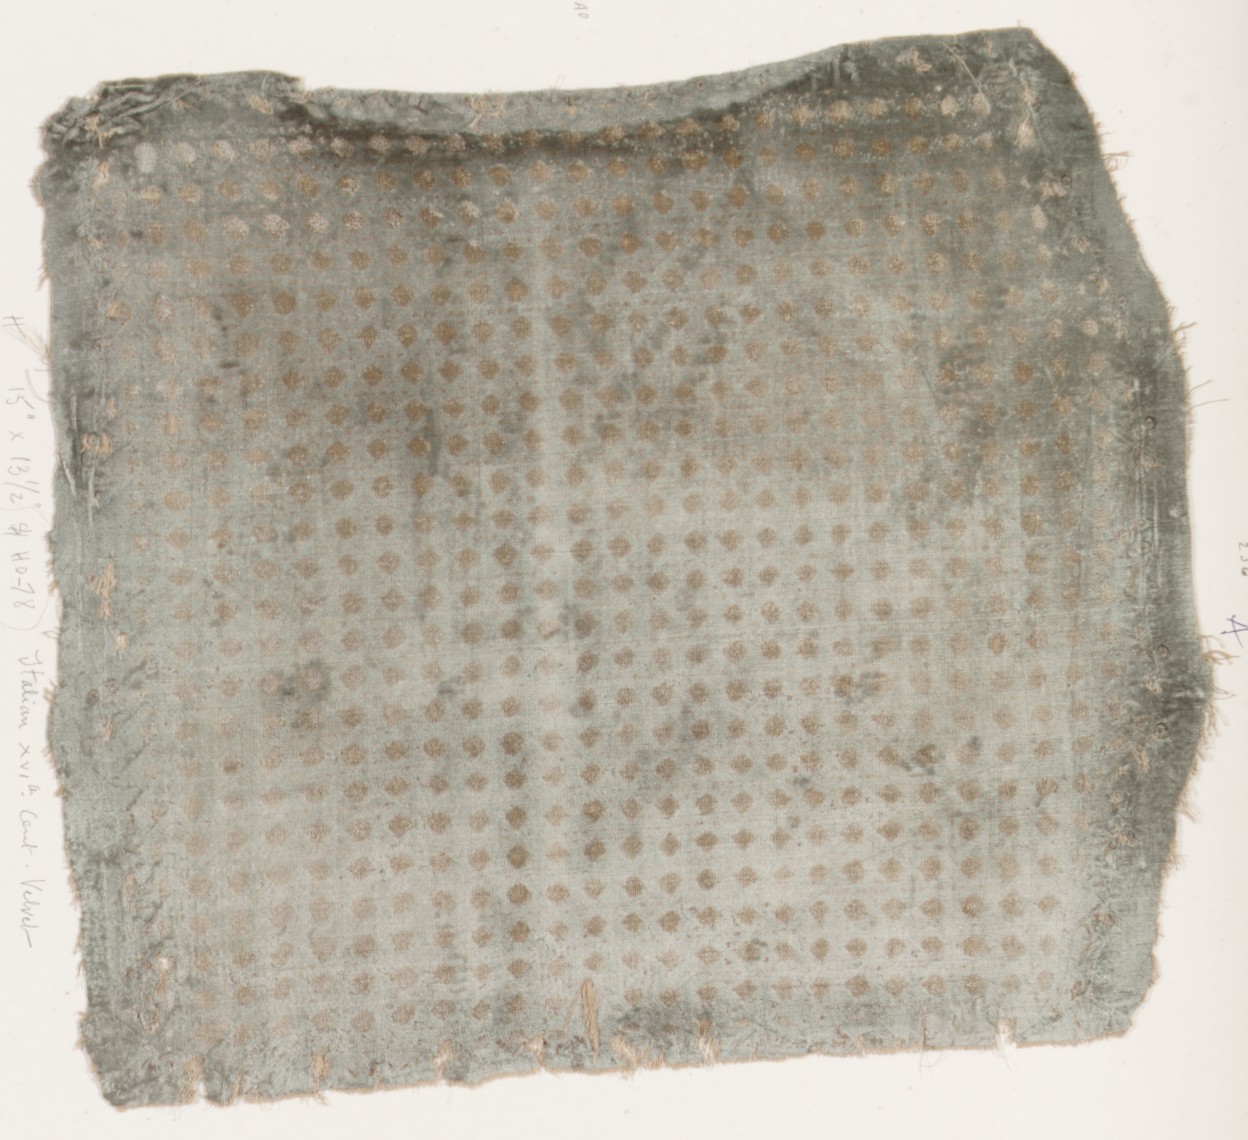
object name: fragment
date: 1501-1600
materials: silk